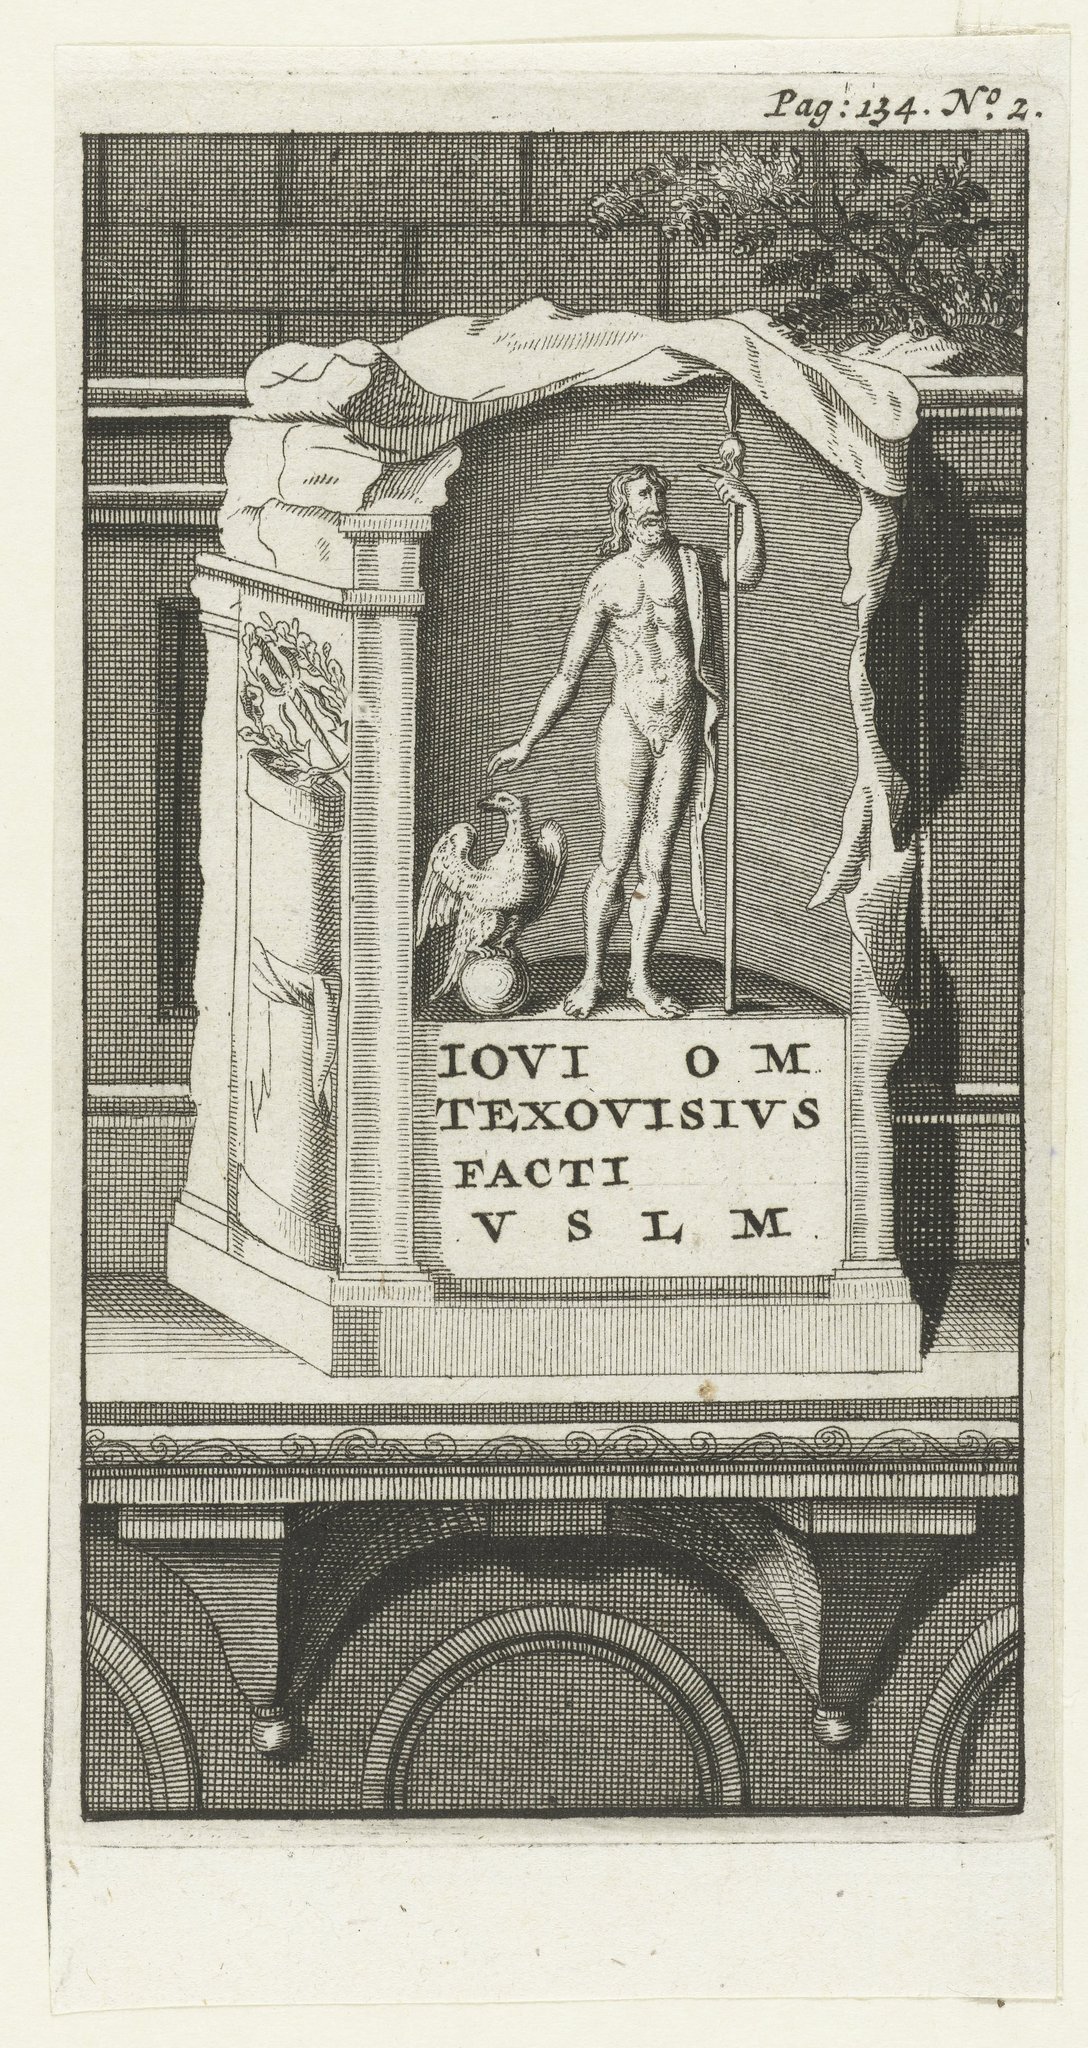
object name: historical object representation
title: Altaar met beeldje van Jupiter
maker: Anonymous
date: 1713-1717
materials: paper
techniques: etching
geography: netherlands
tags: (story of) jupiter (zeus), altar ~ roman religion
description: Illustratie voor: Mattheus Gargon, Walchersche arkadia, Samuel (I) Luchtmans, Leiden 1715-1717, pag. 134 No. 2.